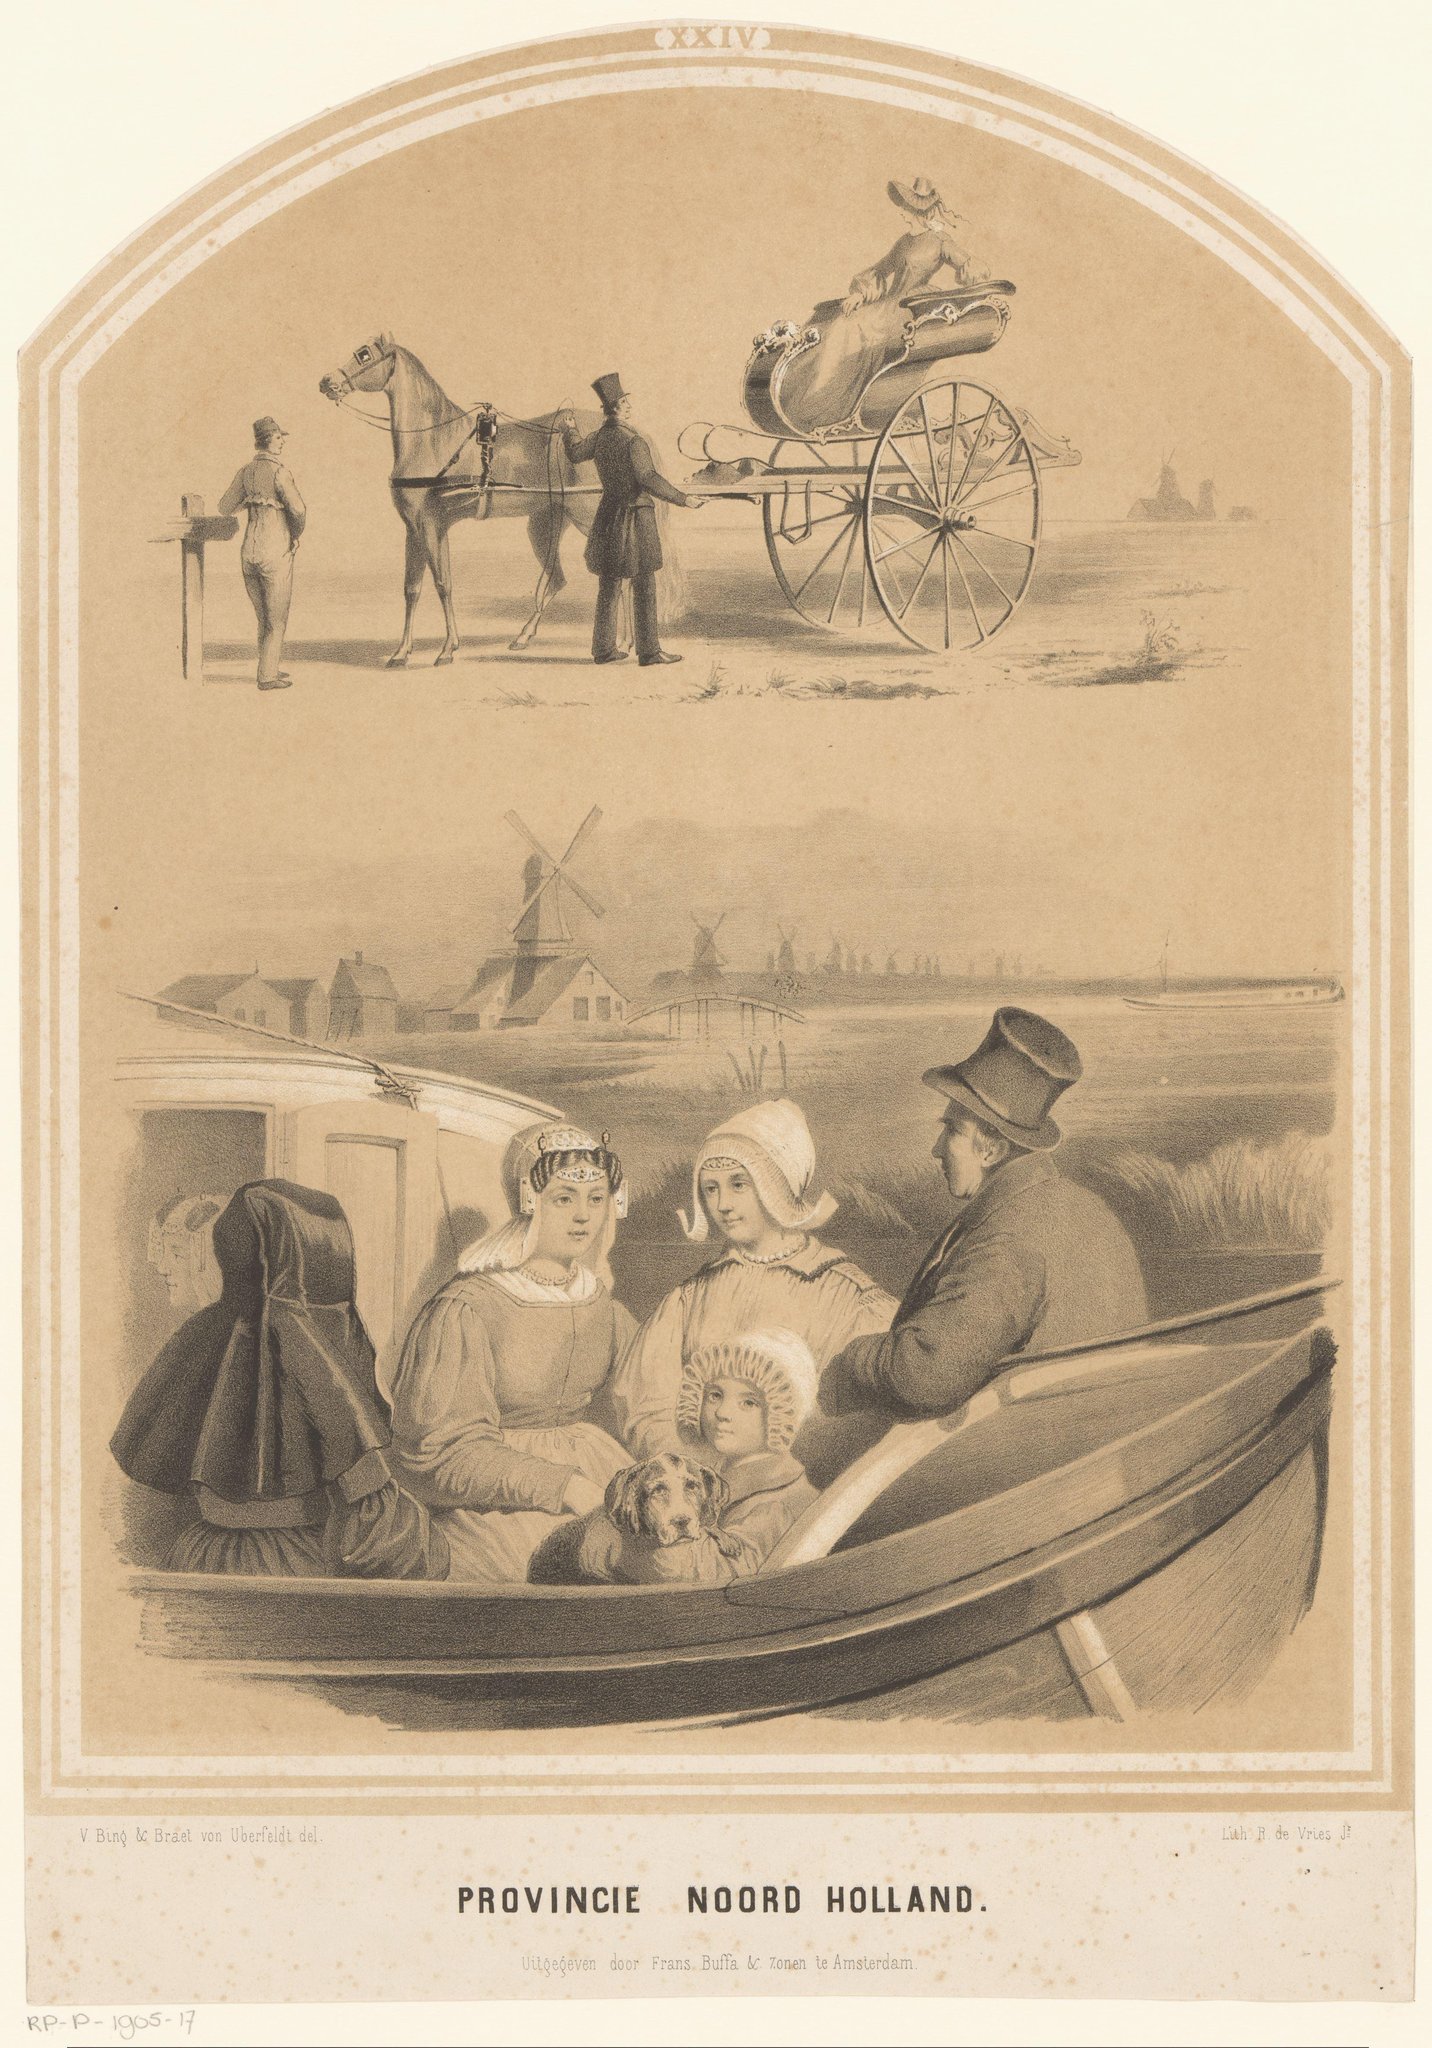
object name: print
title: Nederlandsche kleederdragten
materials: paper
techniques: tone lithography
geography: amsterdam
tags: folk costume, regional costume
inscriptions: collector's mark: Lugt 2228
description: Klederdracht van de provincie Noord-Holland. Aan de bovenzijde een vrouw in een sjees, daaronder een man, vier vrouwen en een meisje in een trekschuit. In de achtergrond een landschap met molens.